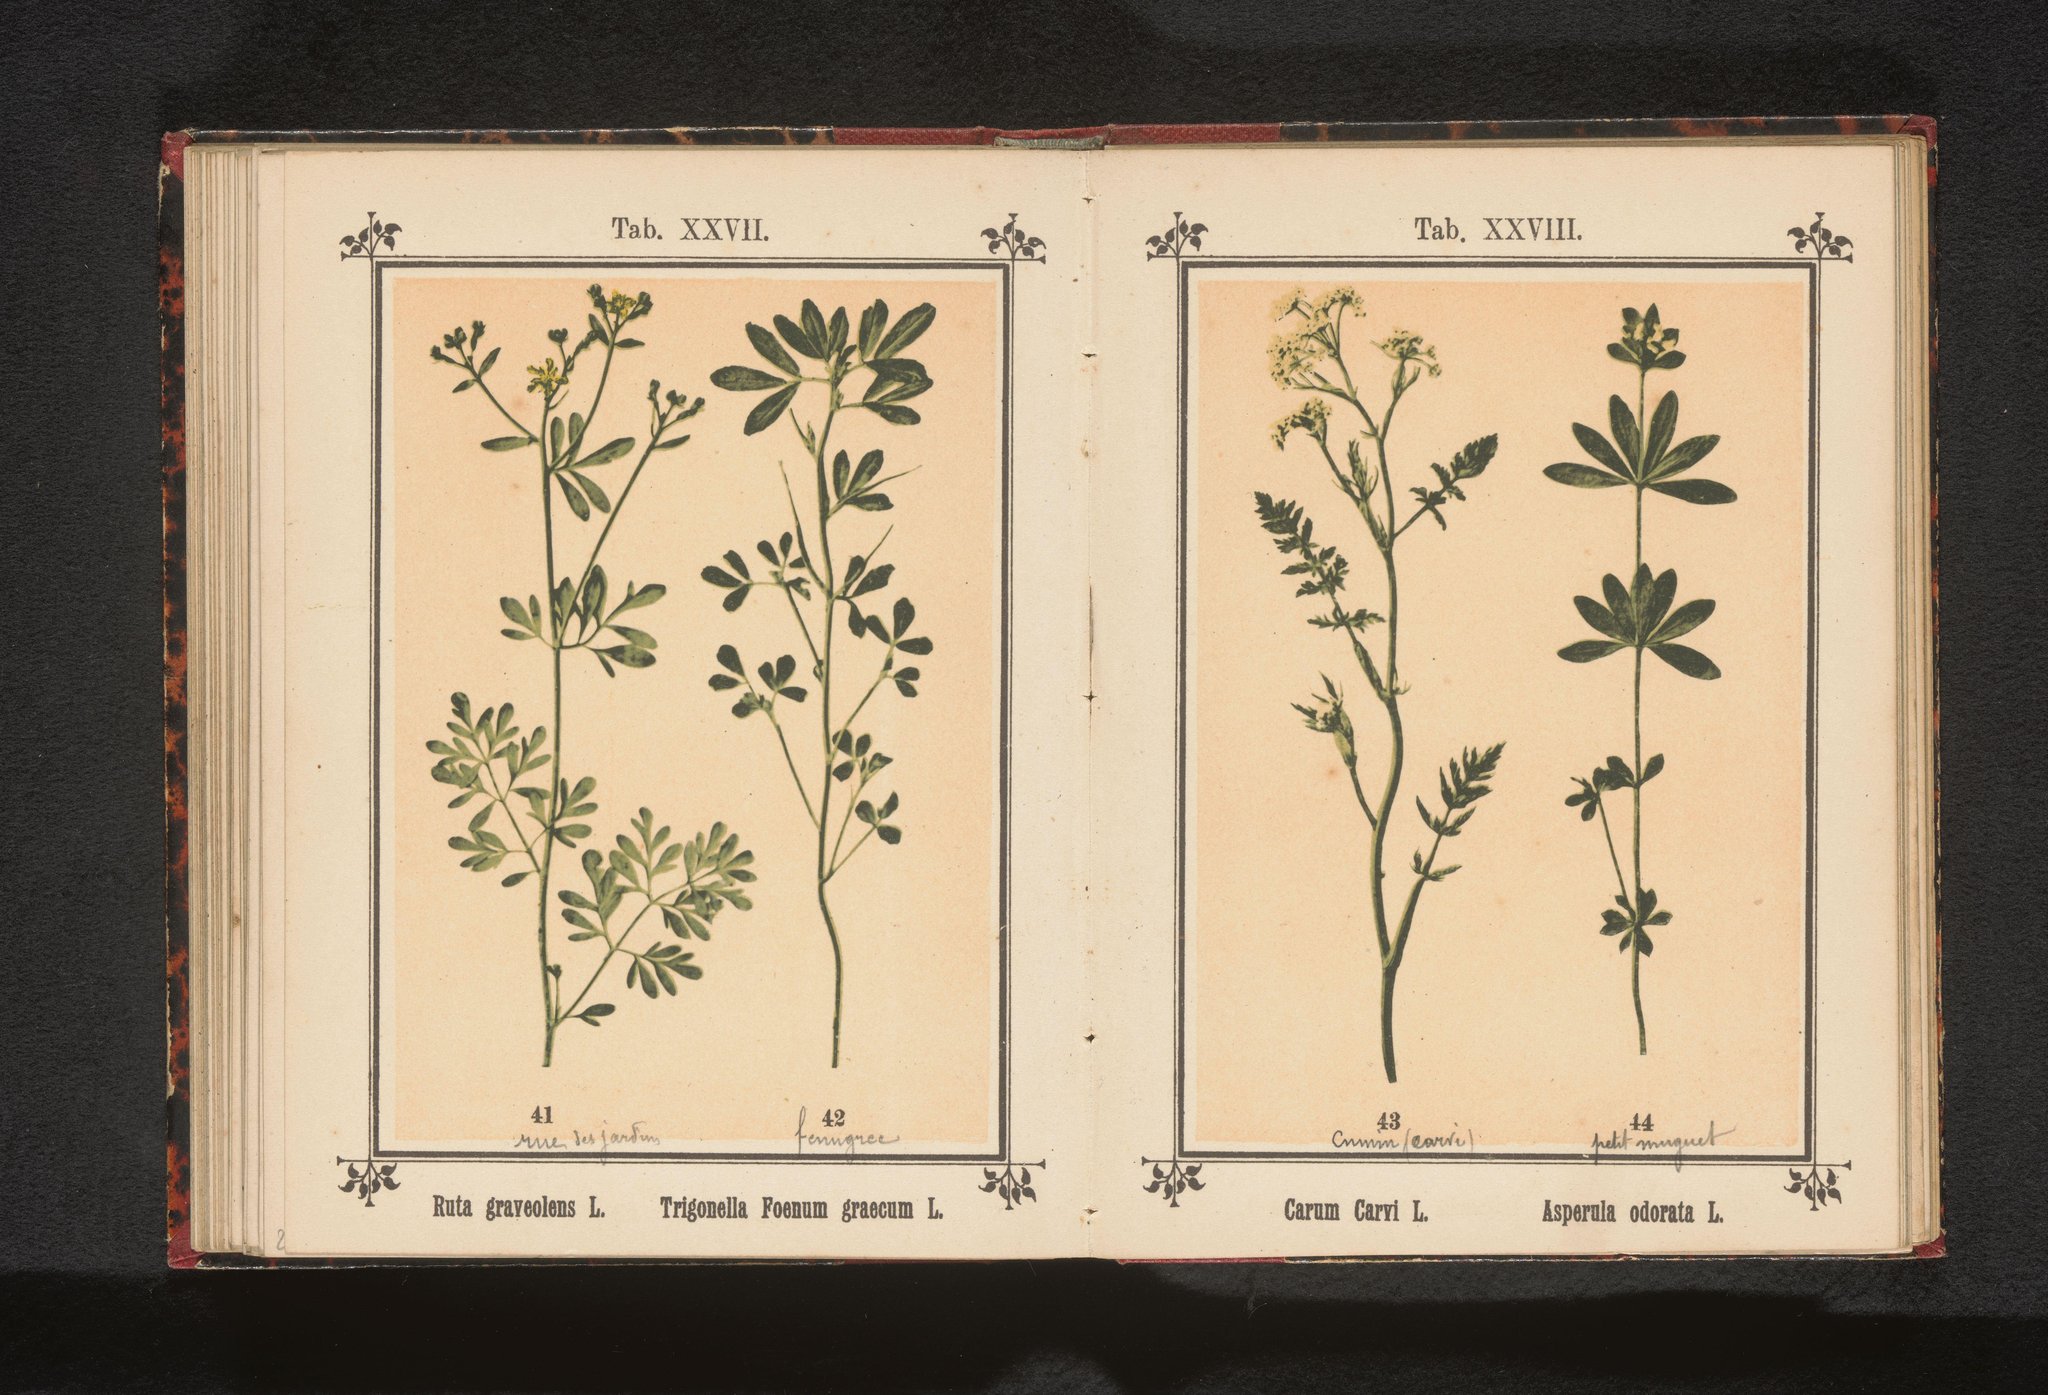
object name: photomechanical print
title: Karwij en lievevrouwebedstro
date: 1884-1894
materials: paper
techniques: photograph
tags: plants and herbs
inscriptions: number: ‘Tab. XXVIII.’, inscription: ‘cumin (carvi) petit muguet’